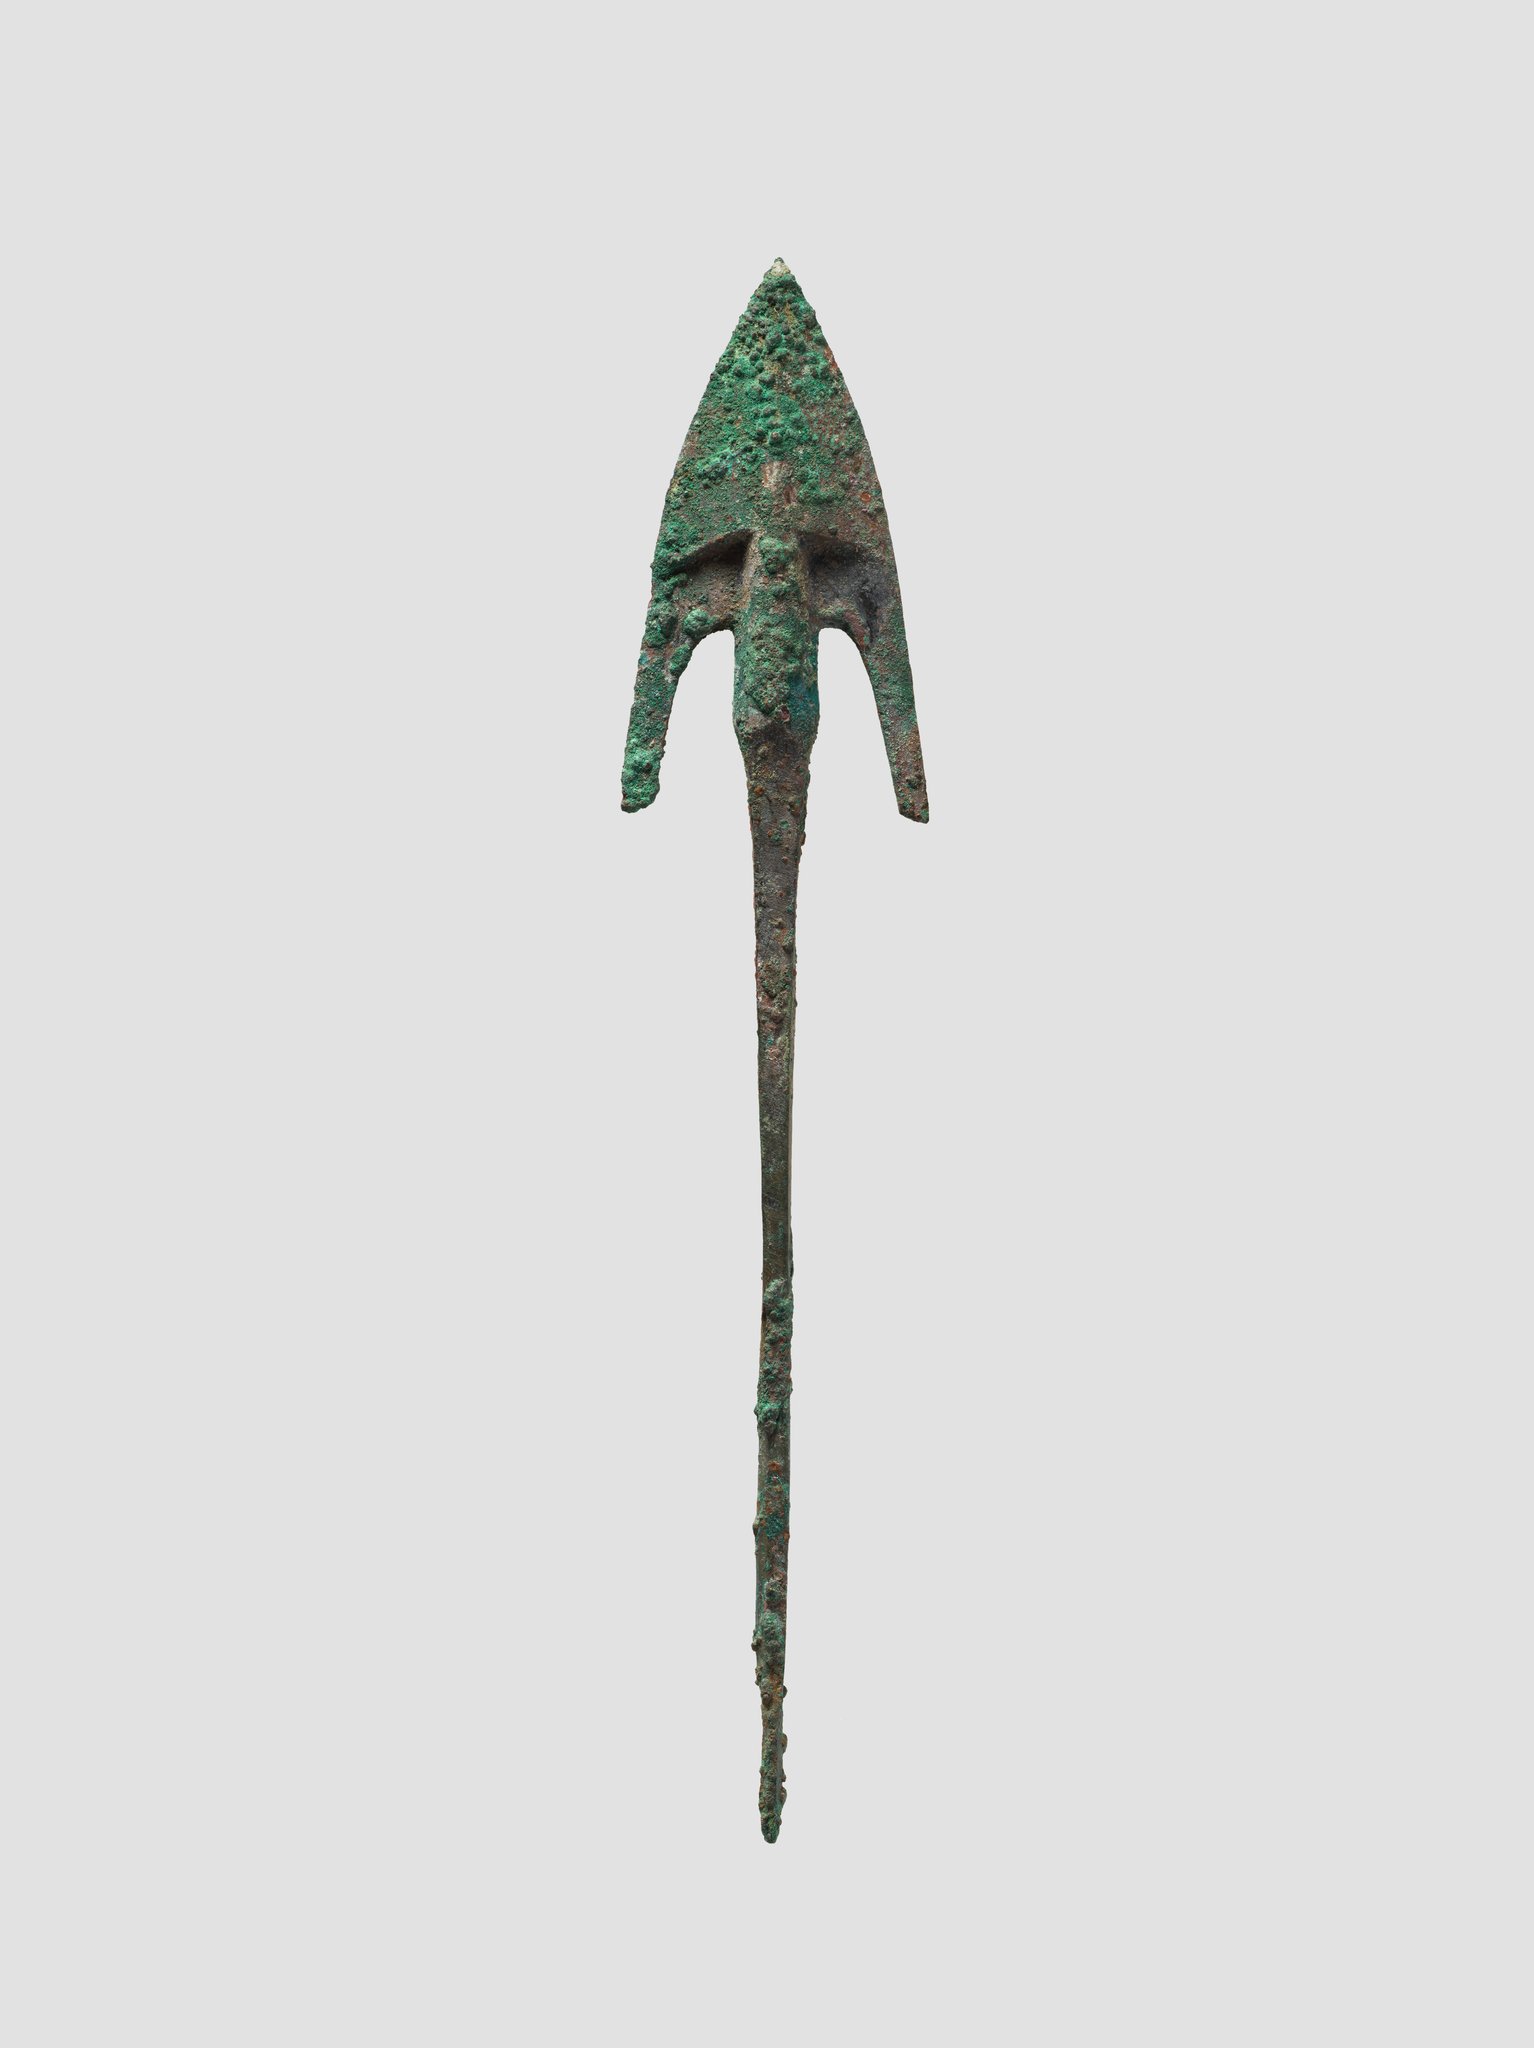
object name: arrowhead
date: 1000-668 BCE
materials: bronze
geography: transcaucasia